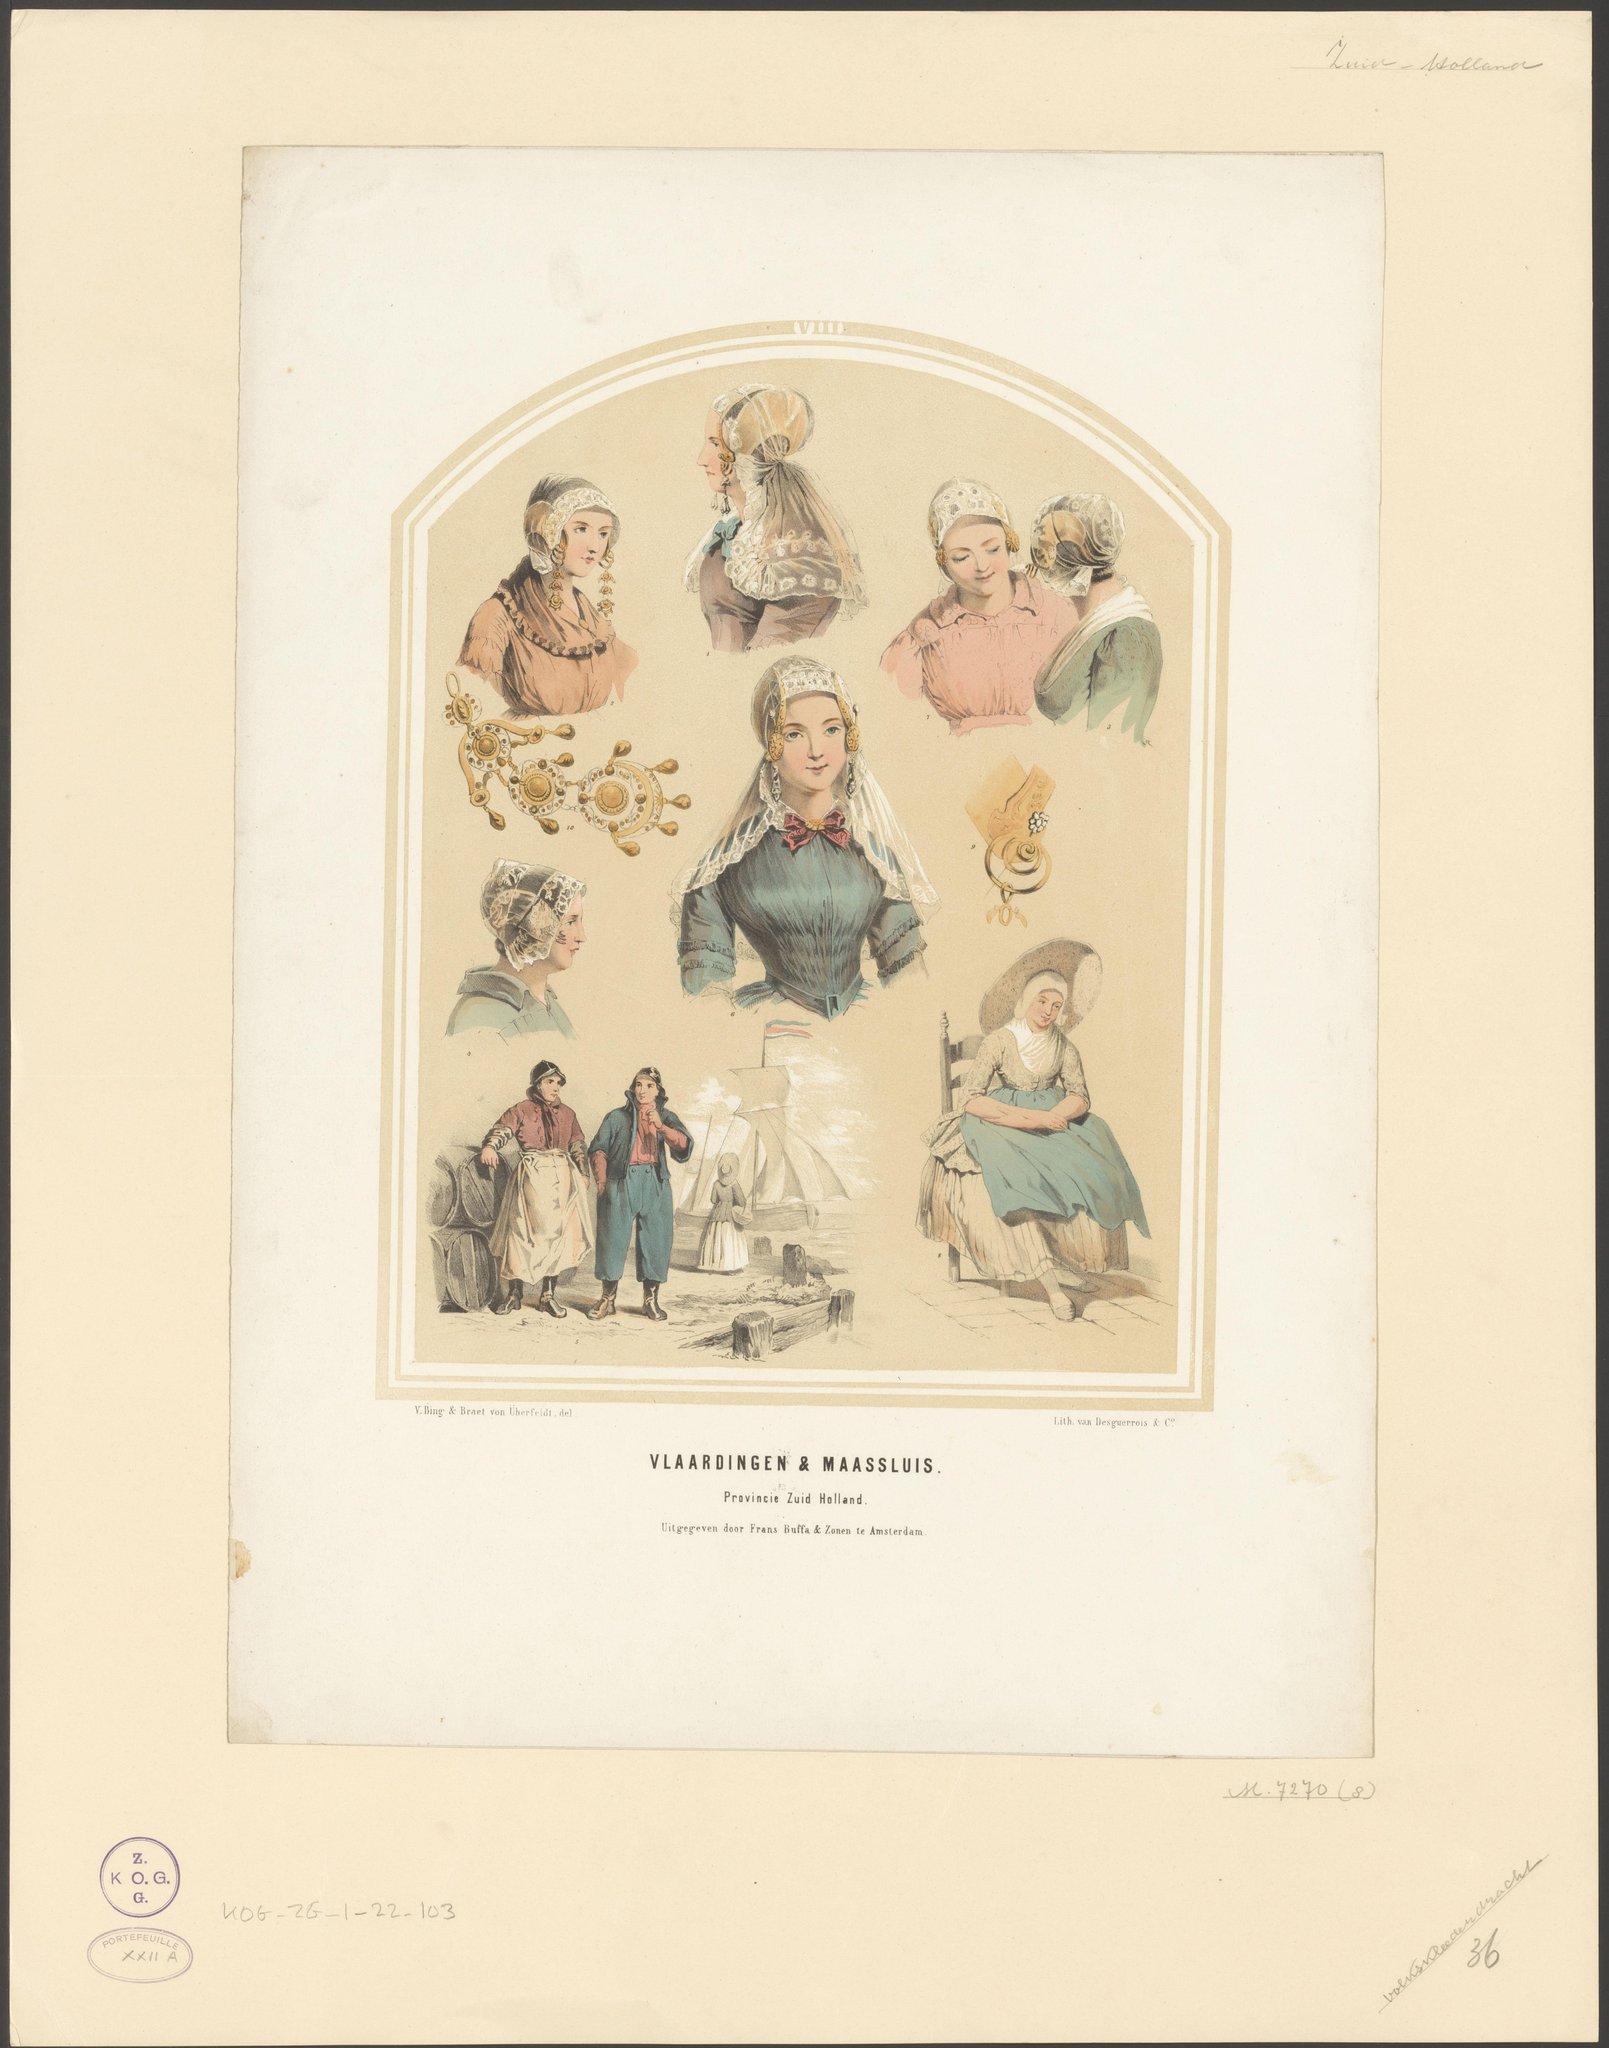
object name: print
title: Vlaardingen & Maassluis. Provincie Zuid-Holland / VIII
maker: jan braet von uberfeldt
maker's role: draughtsman, print maker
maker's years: 1807-1894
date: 1857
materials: paper, watercolor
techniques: hand coloring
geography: netherlands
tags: head-gear (+ women's clothes), clothes, costume (+ women's clothes), folk costume, regional costume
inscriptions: collector's mark: Lugt 1641, collector's mark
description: Klederdracht van Vlaardingen en vooral hoofddracht: details van oorijzers, sieraden en kappen van vrouwen. Illustratie uit een boek uit 1857 met 56 platen van Nederlandse klederdrachten. Onderwerpsrubrieken binnen de Atlas Zeden en Gewoonten: De Kleeding, Volkskleederdracht, Zuid-Holland.